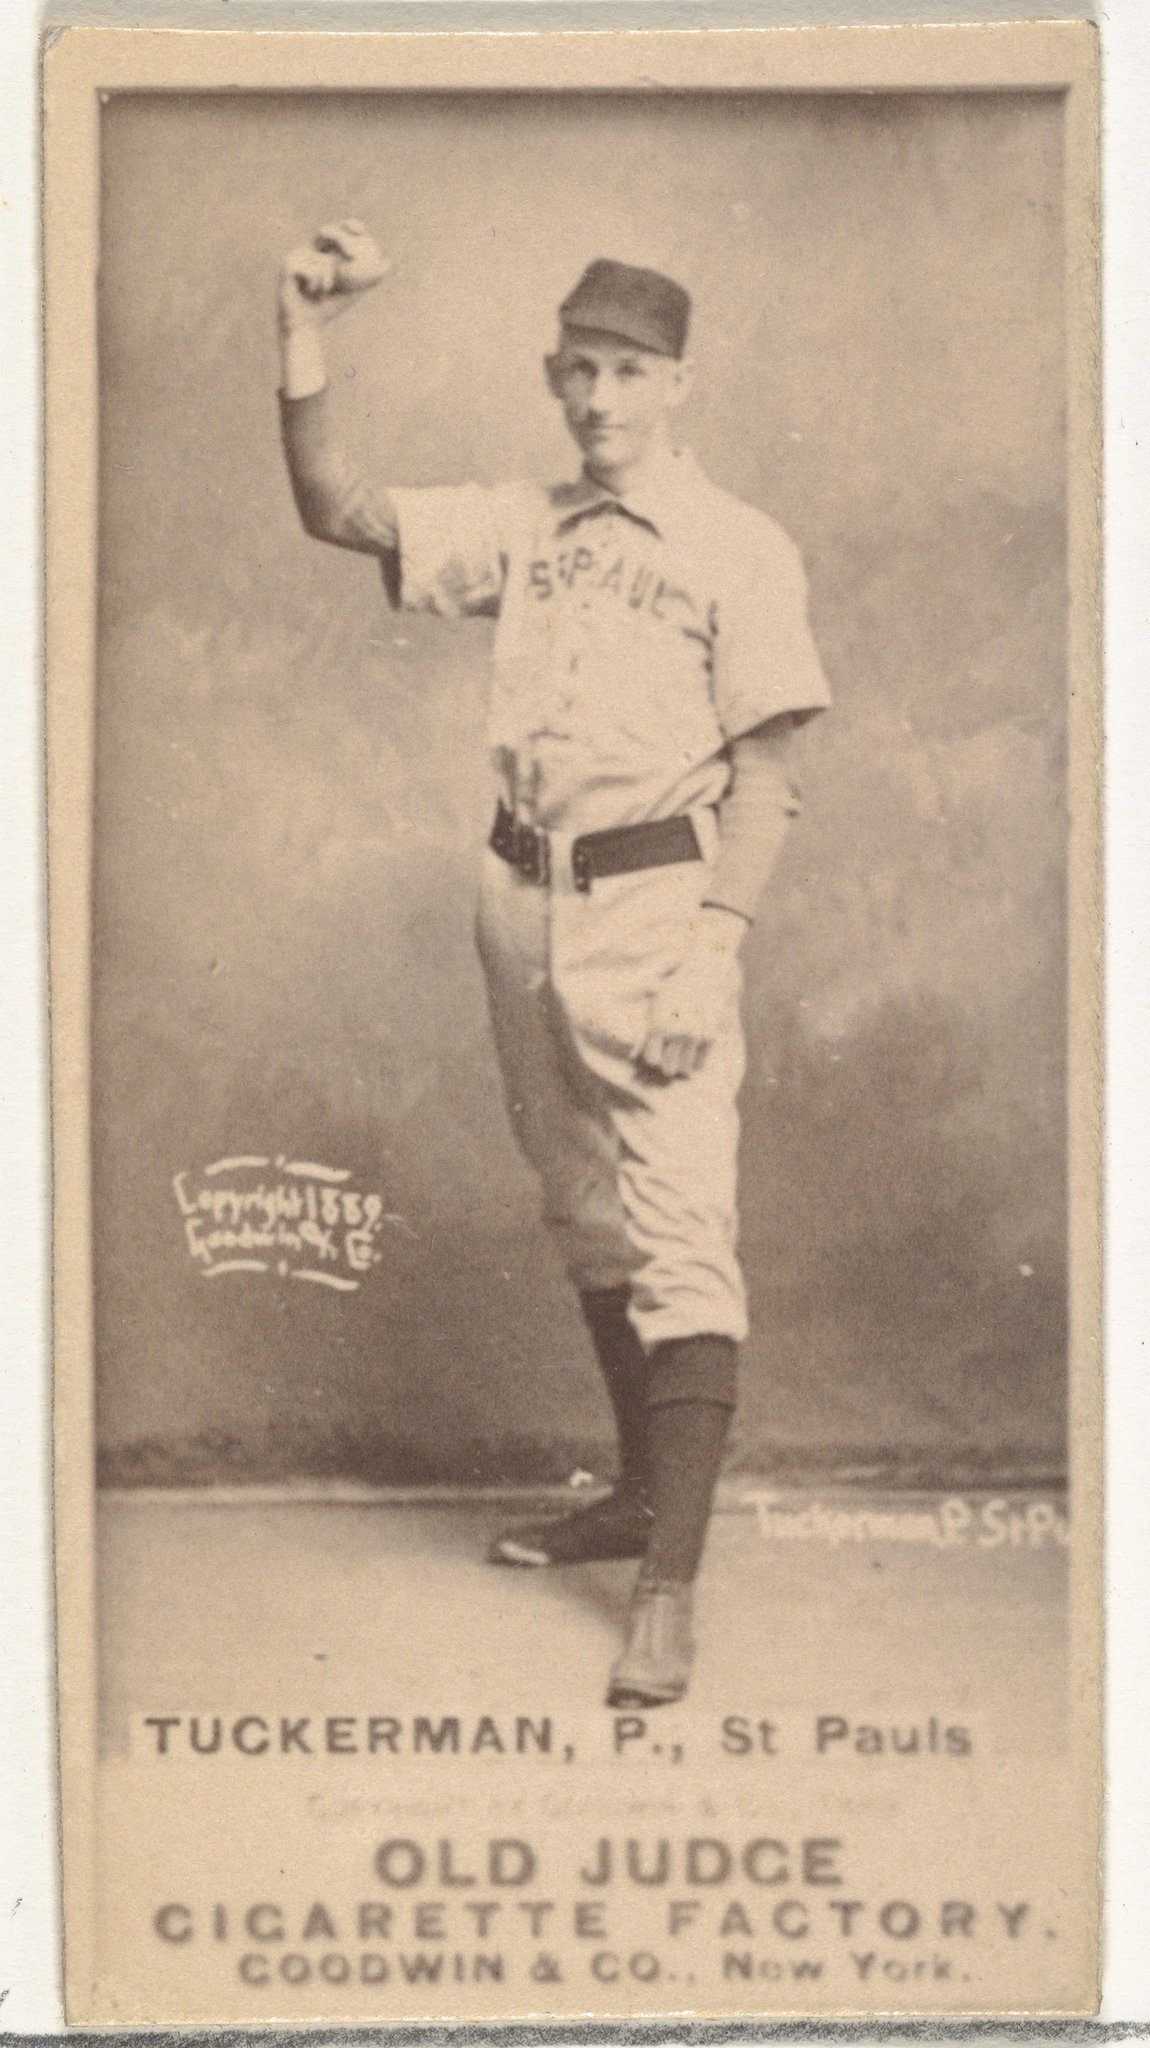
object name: baseball card, photograph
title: William H. Tuckerman, Pitcher, St. Paul Apostles, from the Old Judge series (N172) for Old Judge Cigarettes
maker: goodwin & company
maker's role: publisher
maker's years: 1850-1950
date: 1889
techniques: albumen silver print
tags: men,portraits,baseball,athletes